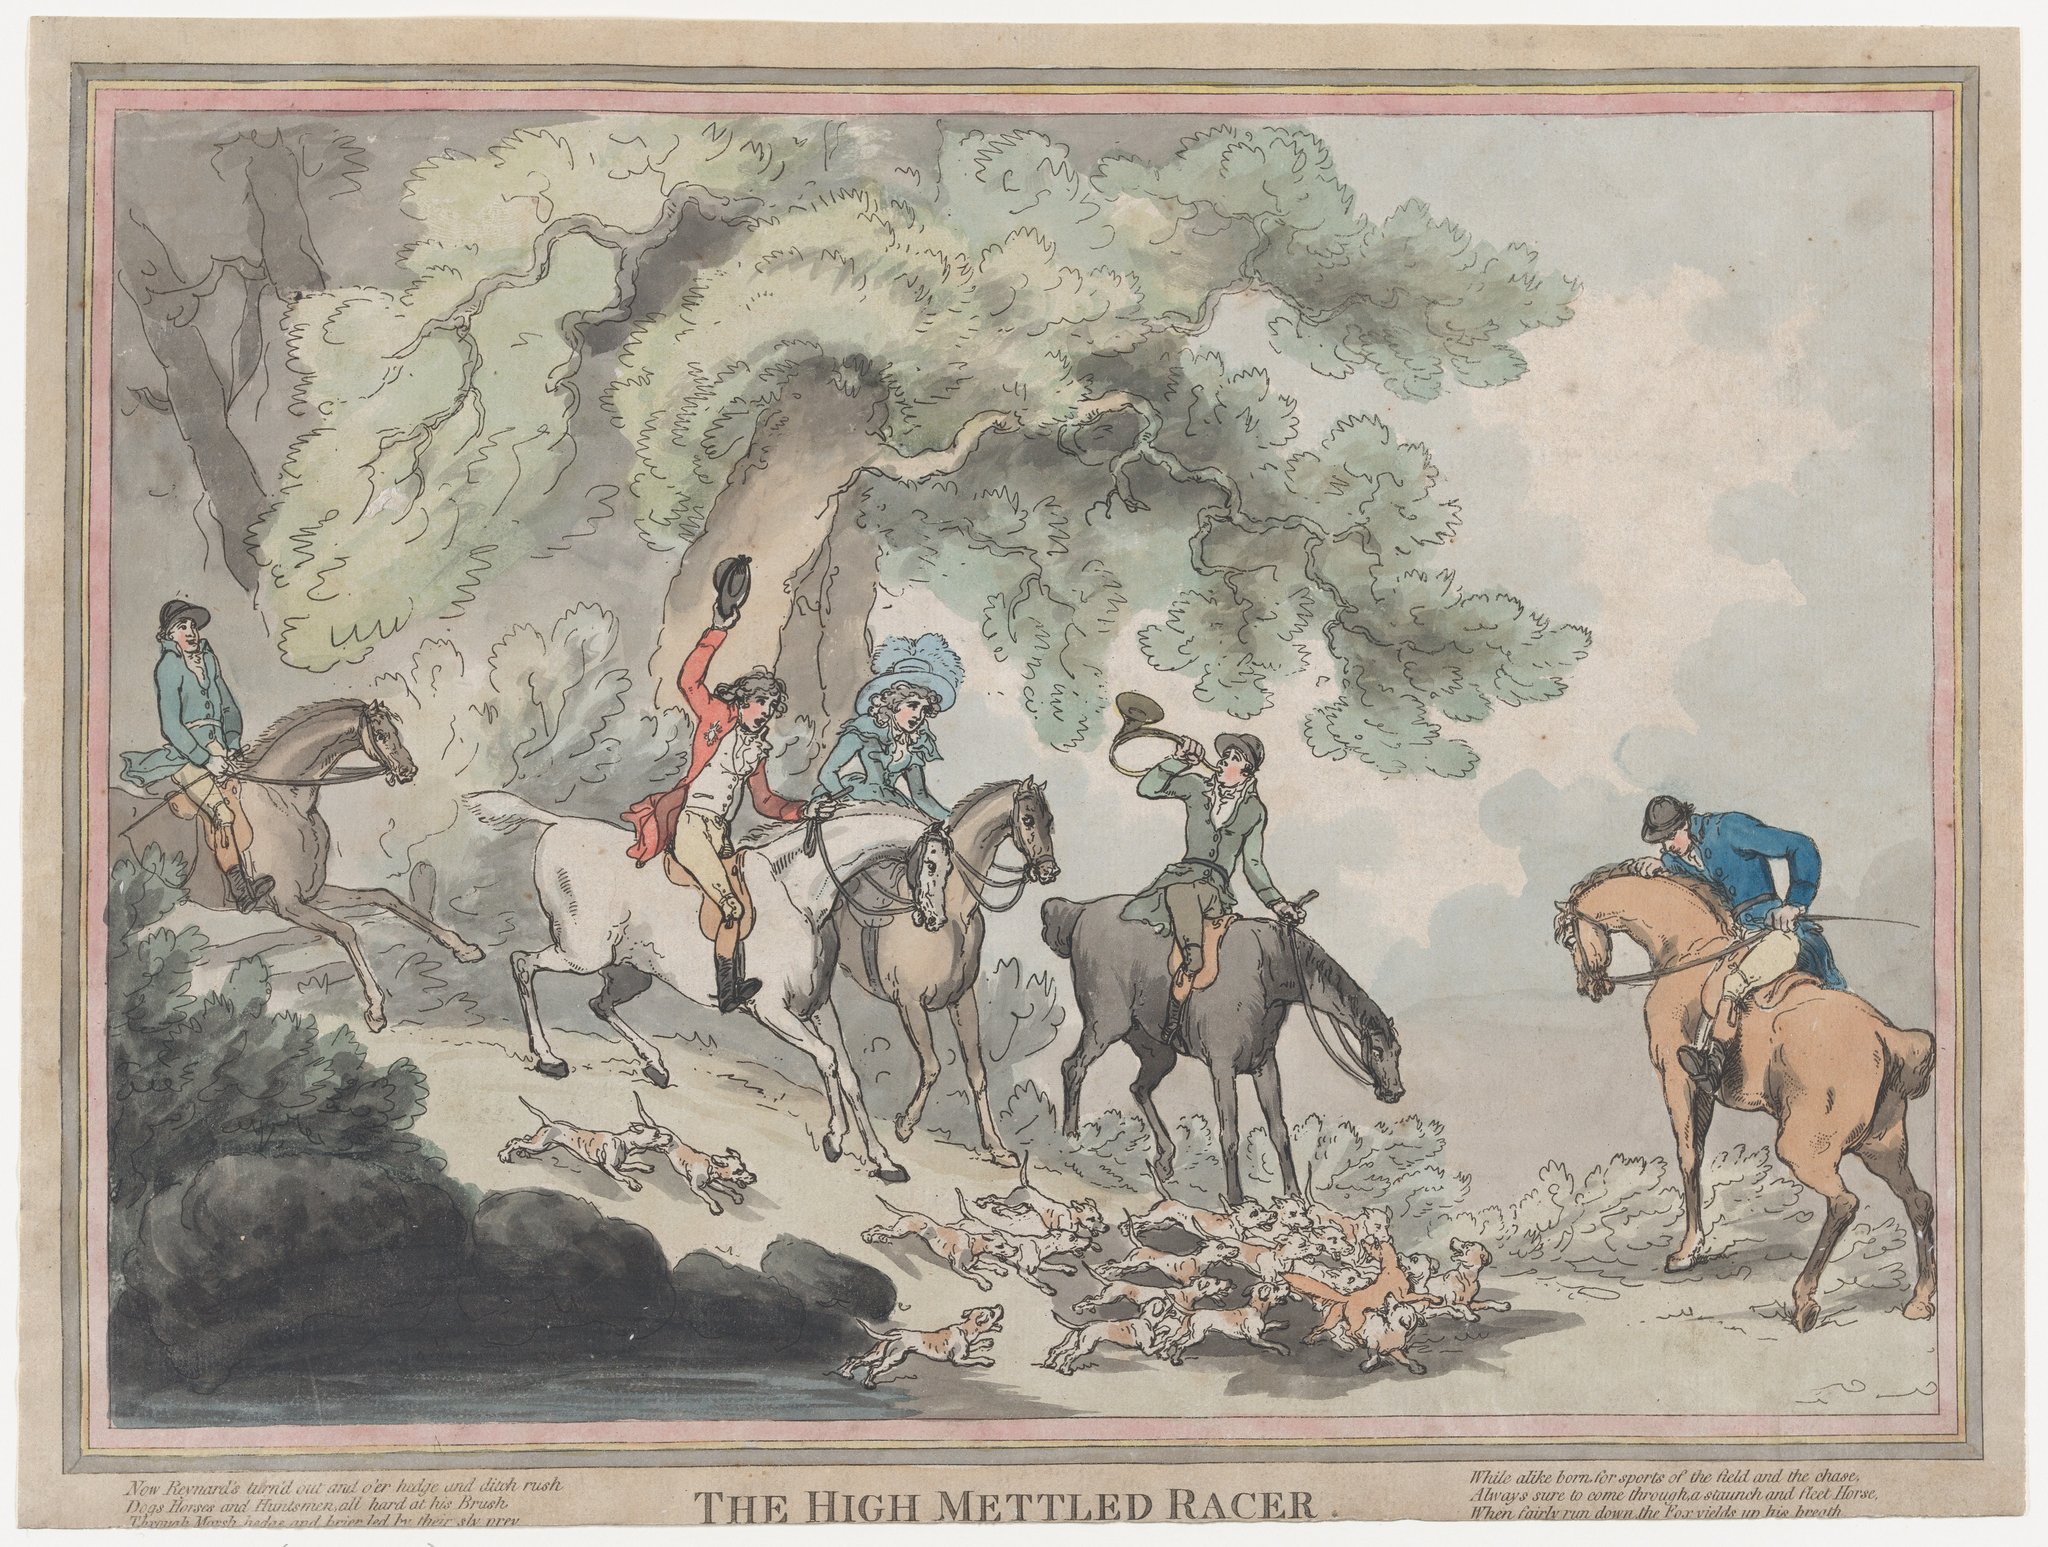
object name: print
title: The Hunter (from The Life of a Racehourse, or The High-Mettled Racer)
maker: thomas rowlandson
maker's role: artist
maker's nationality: british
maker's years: 1757-1827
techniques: aquatint, etching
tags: men,women,dogs,horses